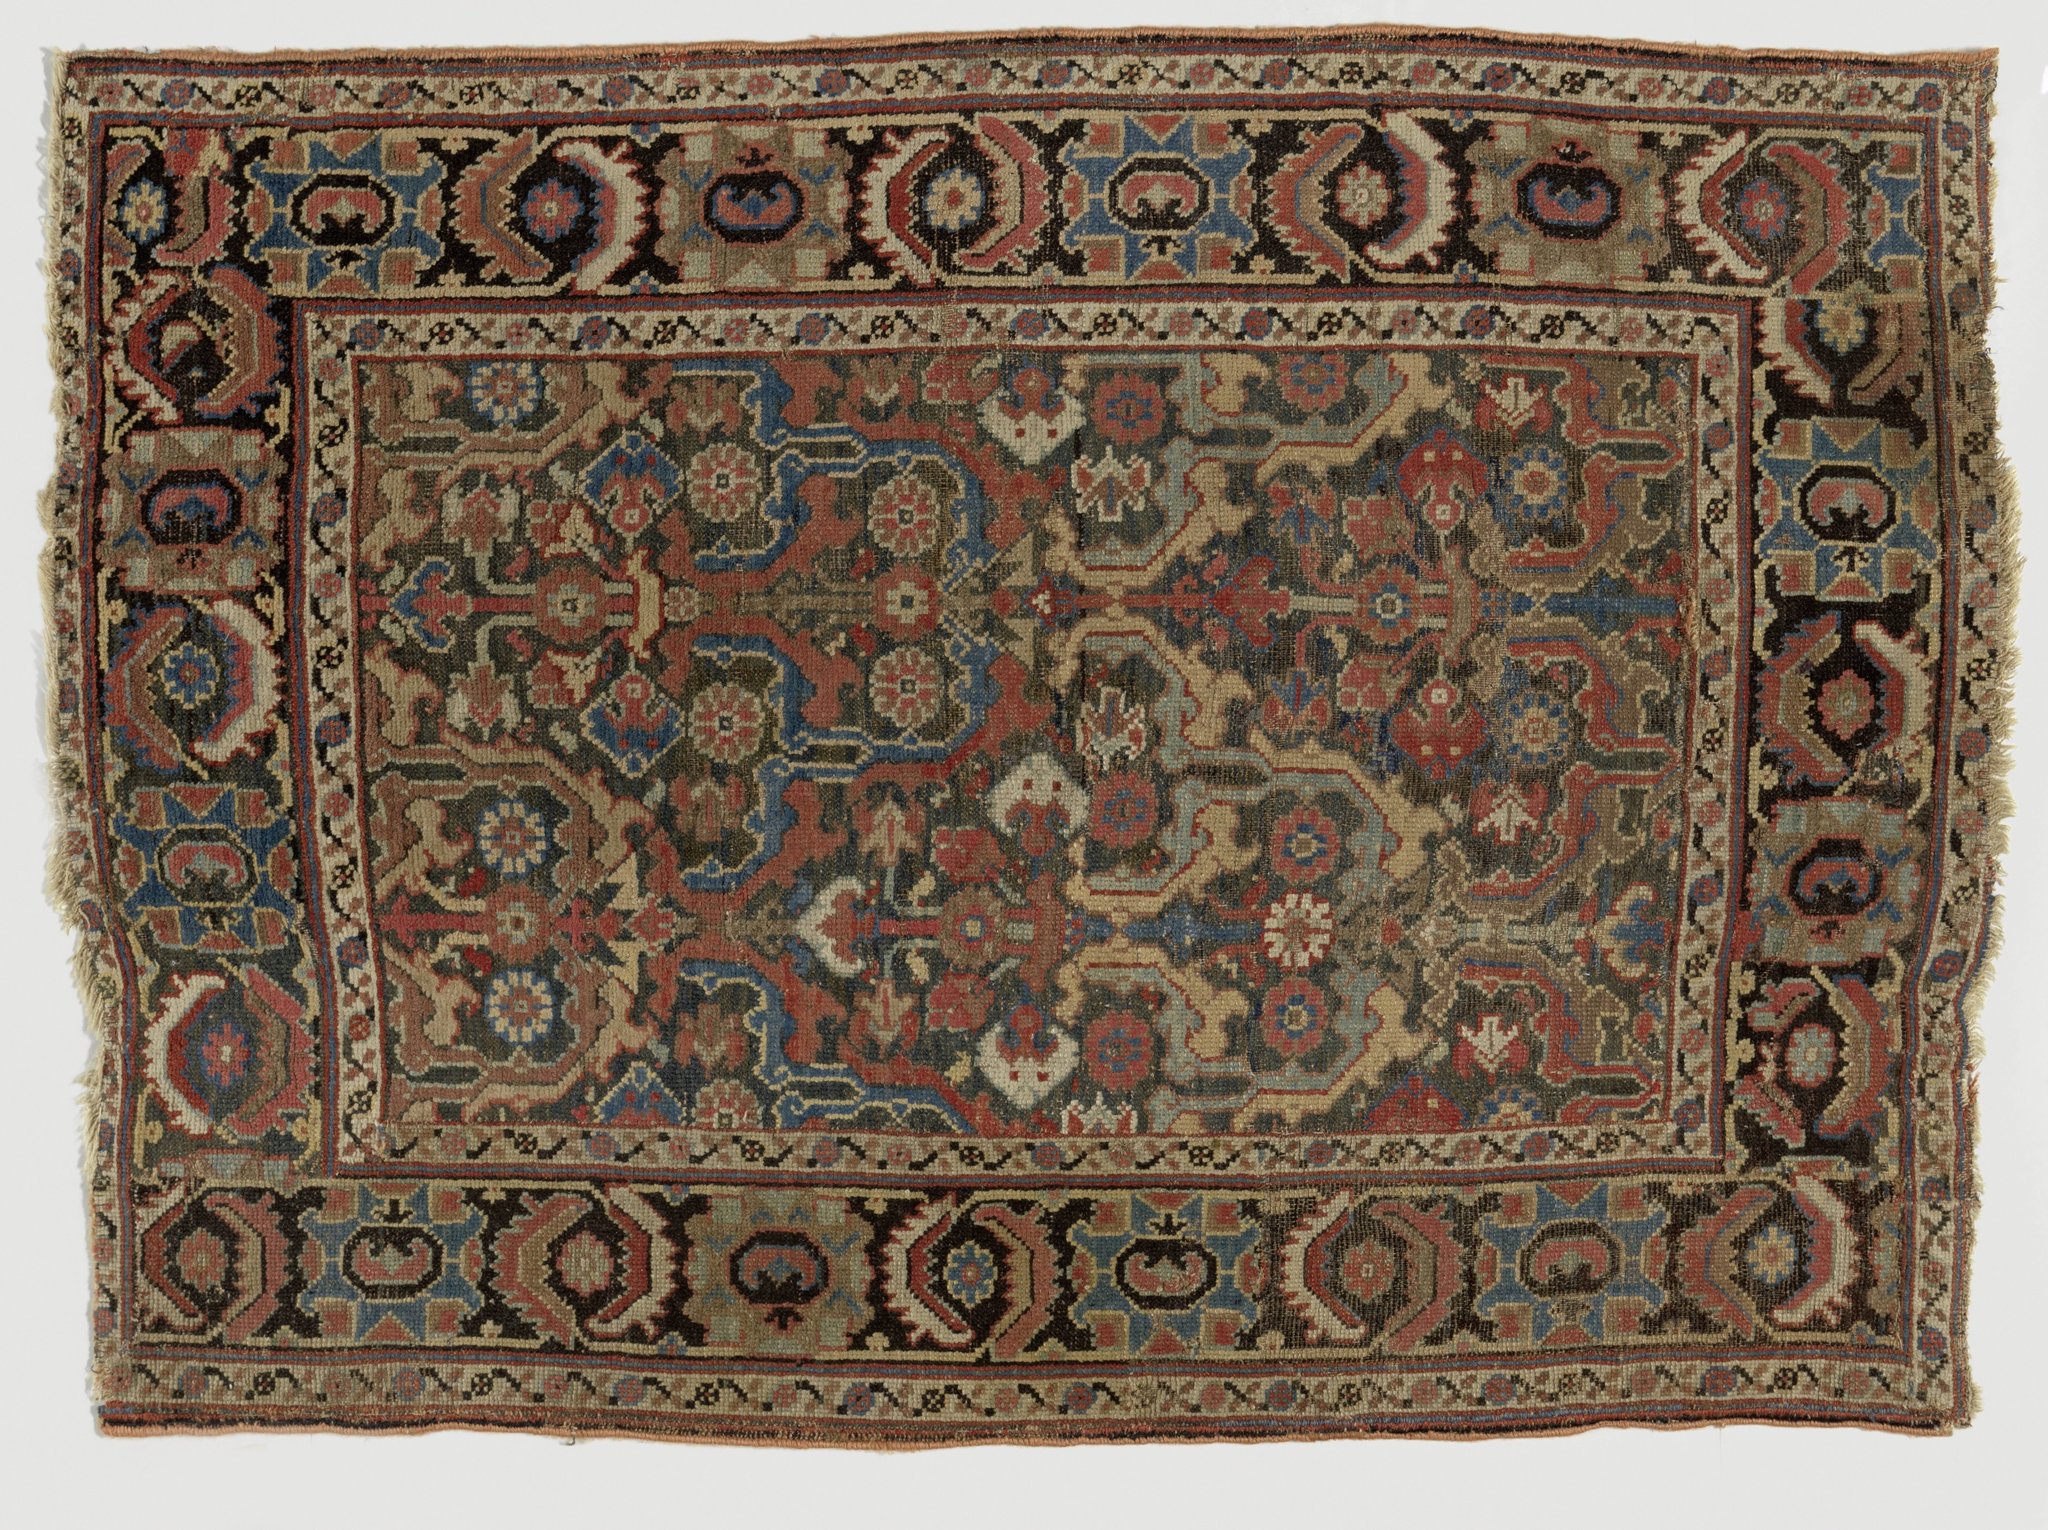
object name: oriental rug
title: Oosters tapijt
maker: Anonymous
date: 1800-1900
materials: wool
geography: ferahan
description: Oosters tapijt, bloemenkleed. In het middenvled hoekige vaasvormen, samengesteld uit arabesken, met bloemboeketten. Drievoudige rand waarvan de breedste versierd is met palmetten en bladmotieven langs s-ranken.